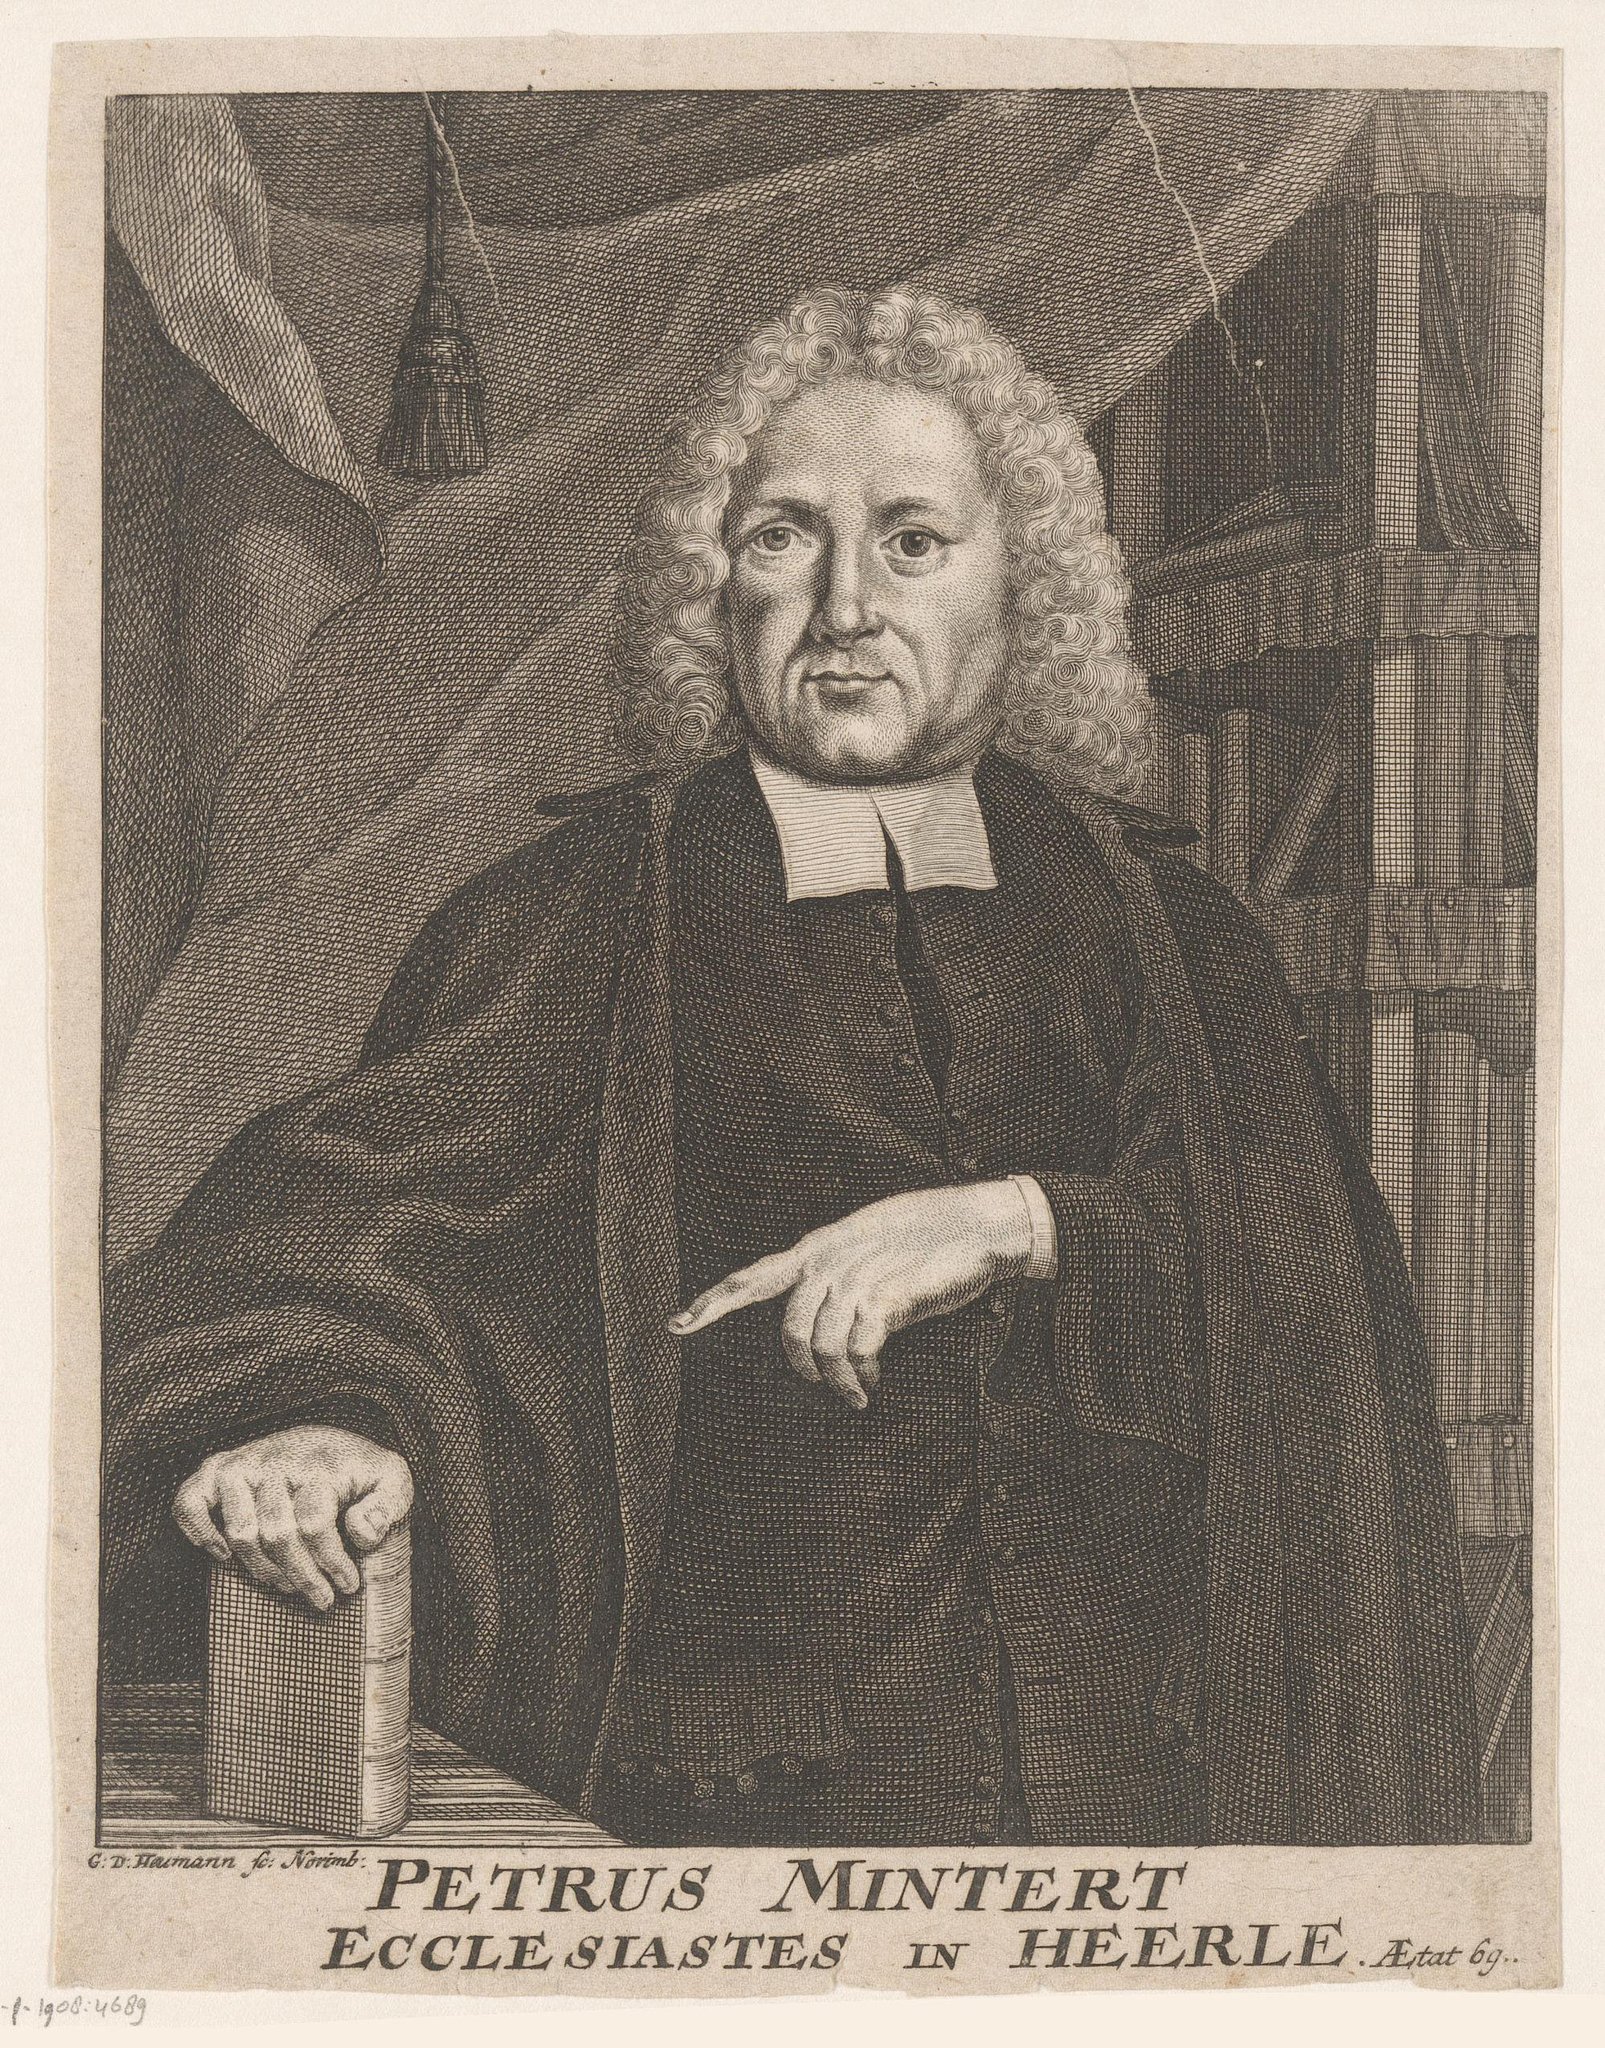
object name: print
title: Portret van Peter Mintert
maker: georg daniel heumann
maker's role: print maker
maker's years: 1691-1759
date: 1701-1759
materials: paper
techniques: engraving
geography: nuremberg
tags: theologian, historical persons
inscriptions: collector's mark: Lugt 2228